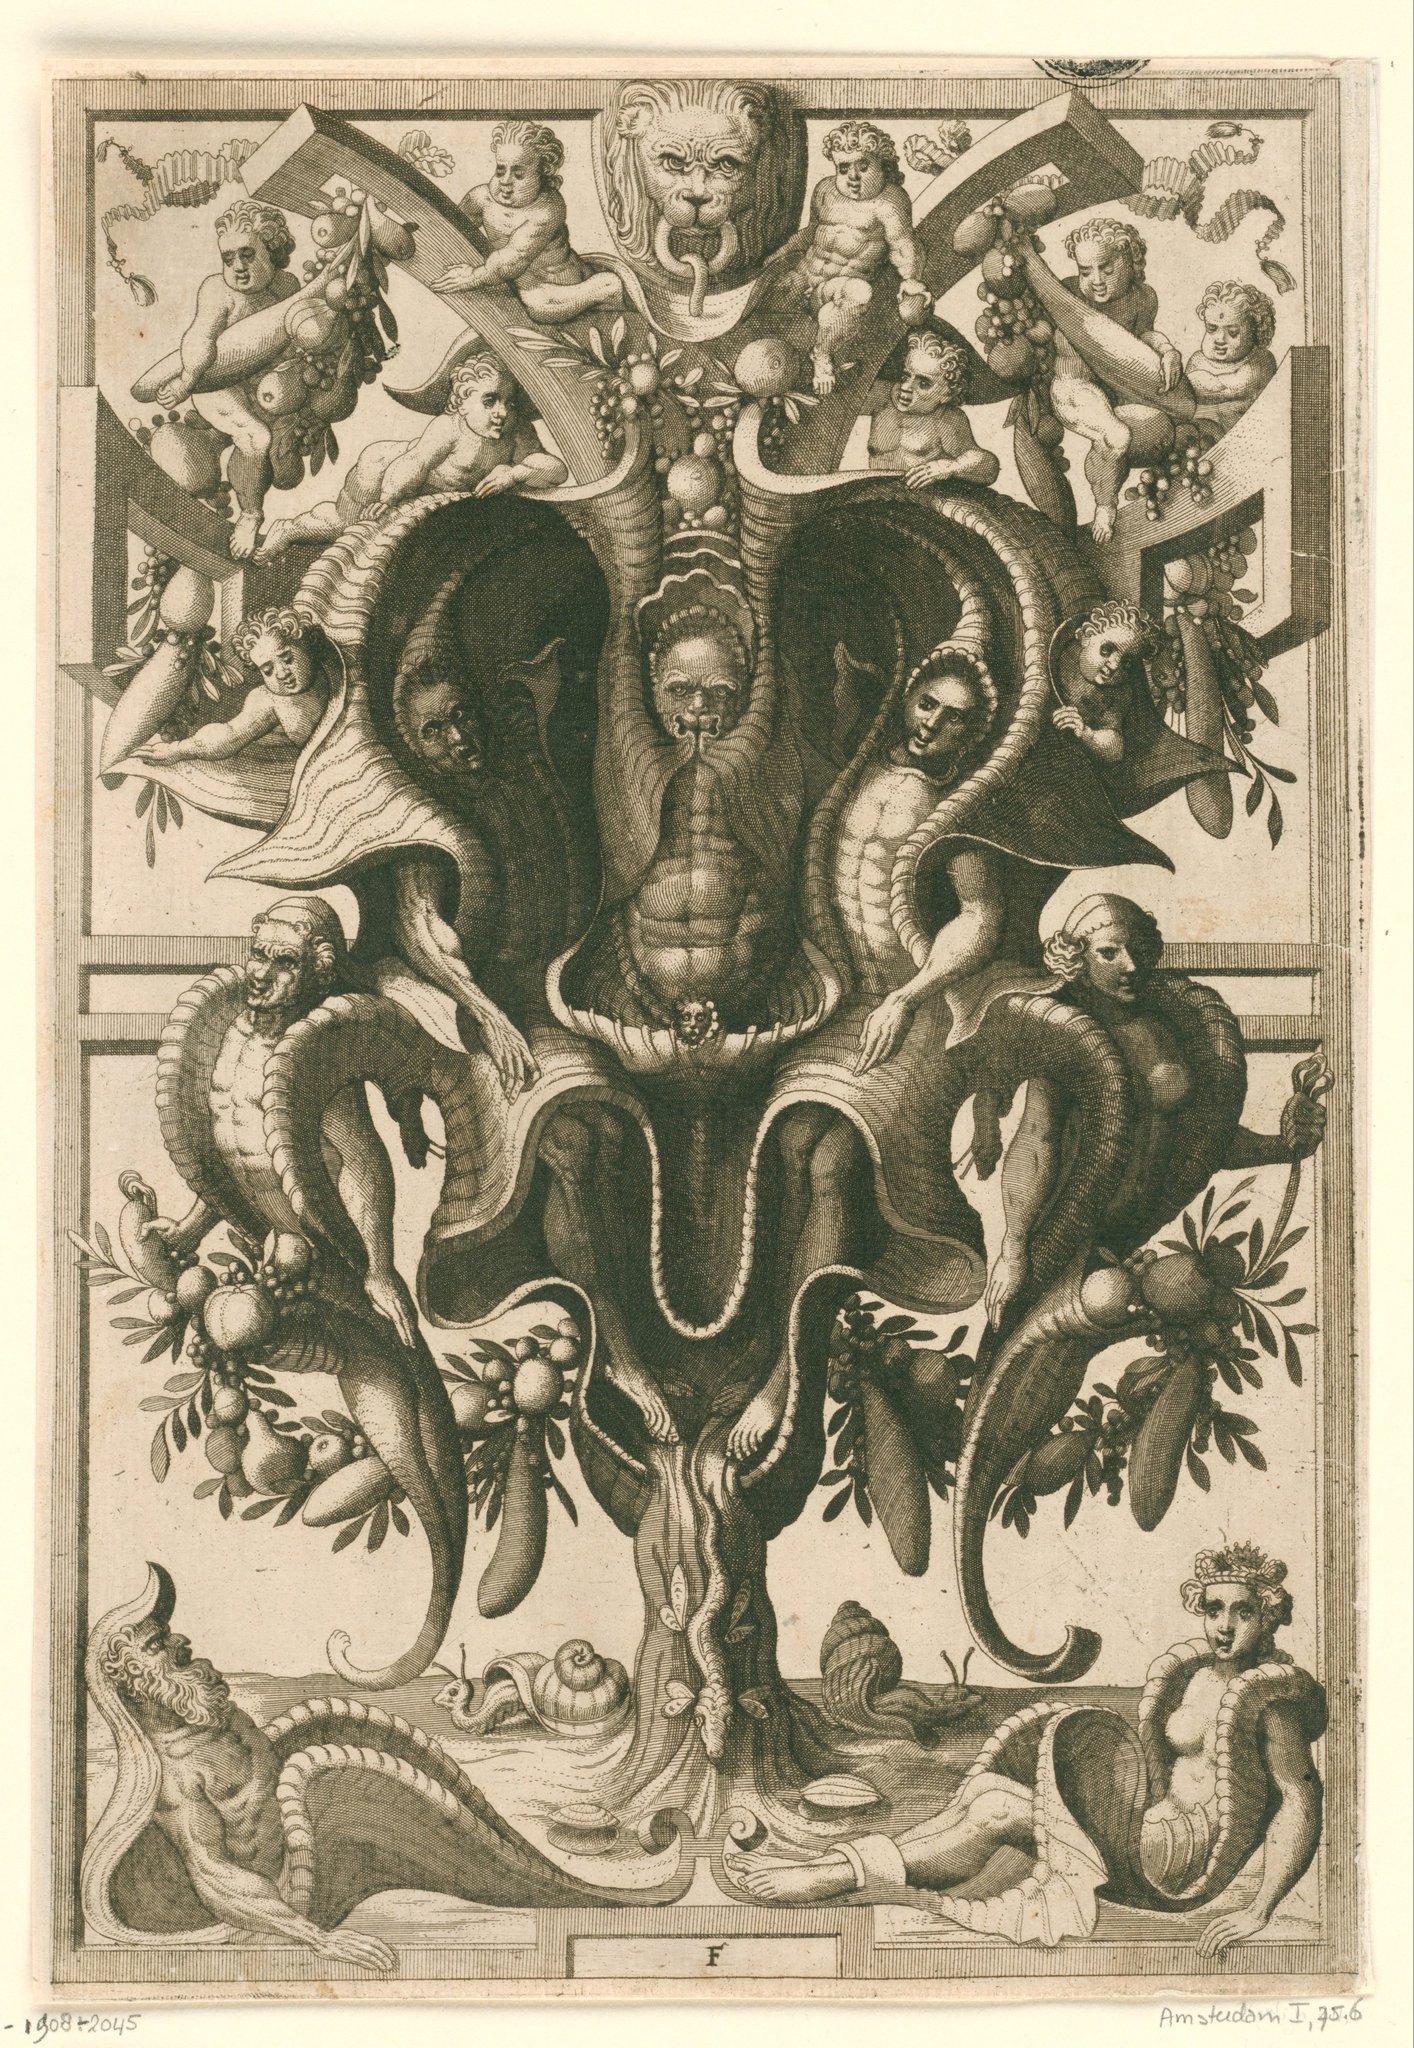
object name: print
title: Veelderleij Veranderinghe van grotissen ende Compertimenten (...)Libro Primo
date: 1556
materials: paper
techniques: etching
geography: netherlands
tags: ornament ~ grotesque, ornament ~ human monstrosities, scallop, shell ~ ornament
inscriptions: inscription: ‘F’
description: Schelpachtig ornament waarin figuren gevangen zitten. Onderaan zitten een man (links) en een vrouw (rechts) vastgeklemd in schelpen. Bovenop klauteren kindertjes rond op uitsteeksels van rolwerk. Blad F uit serie van 12 bladen, genummerd A-M, met vlakdecoraties van grotesken met rolwerk, saters, guirlandes, trofeeën, dieren en fantasiewezens